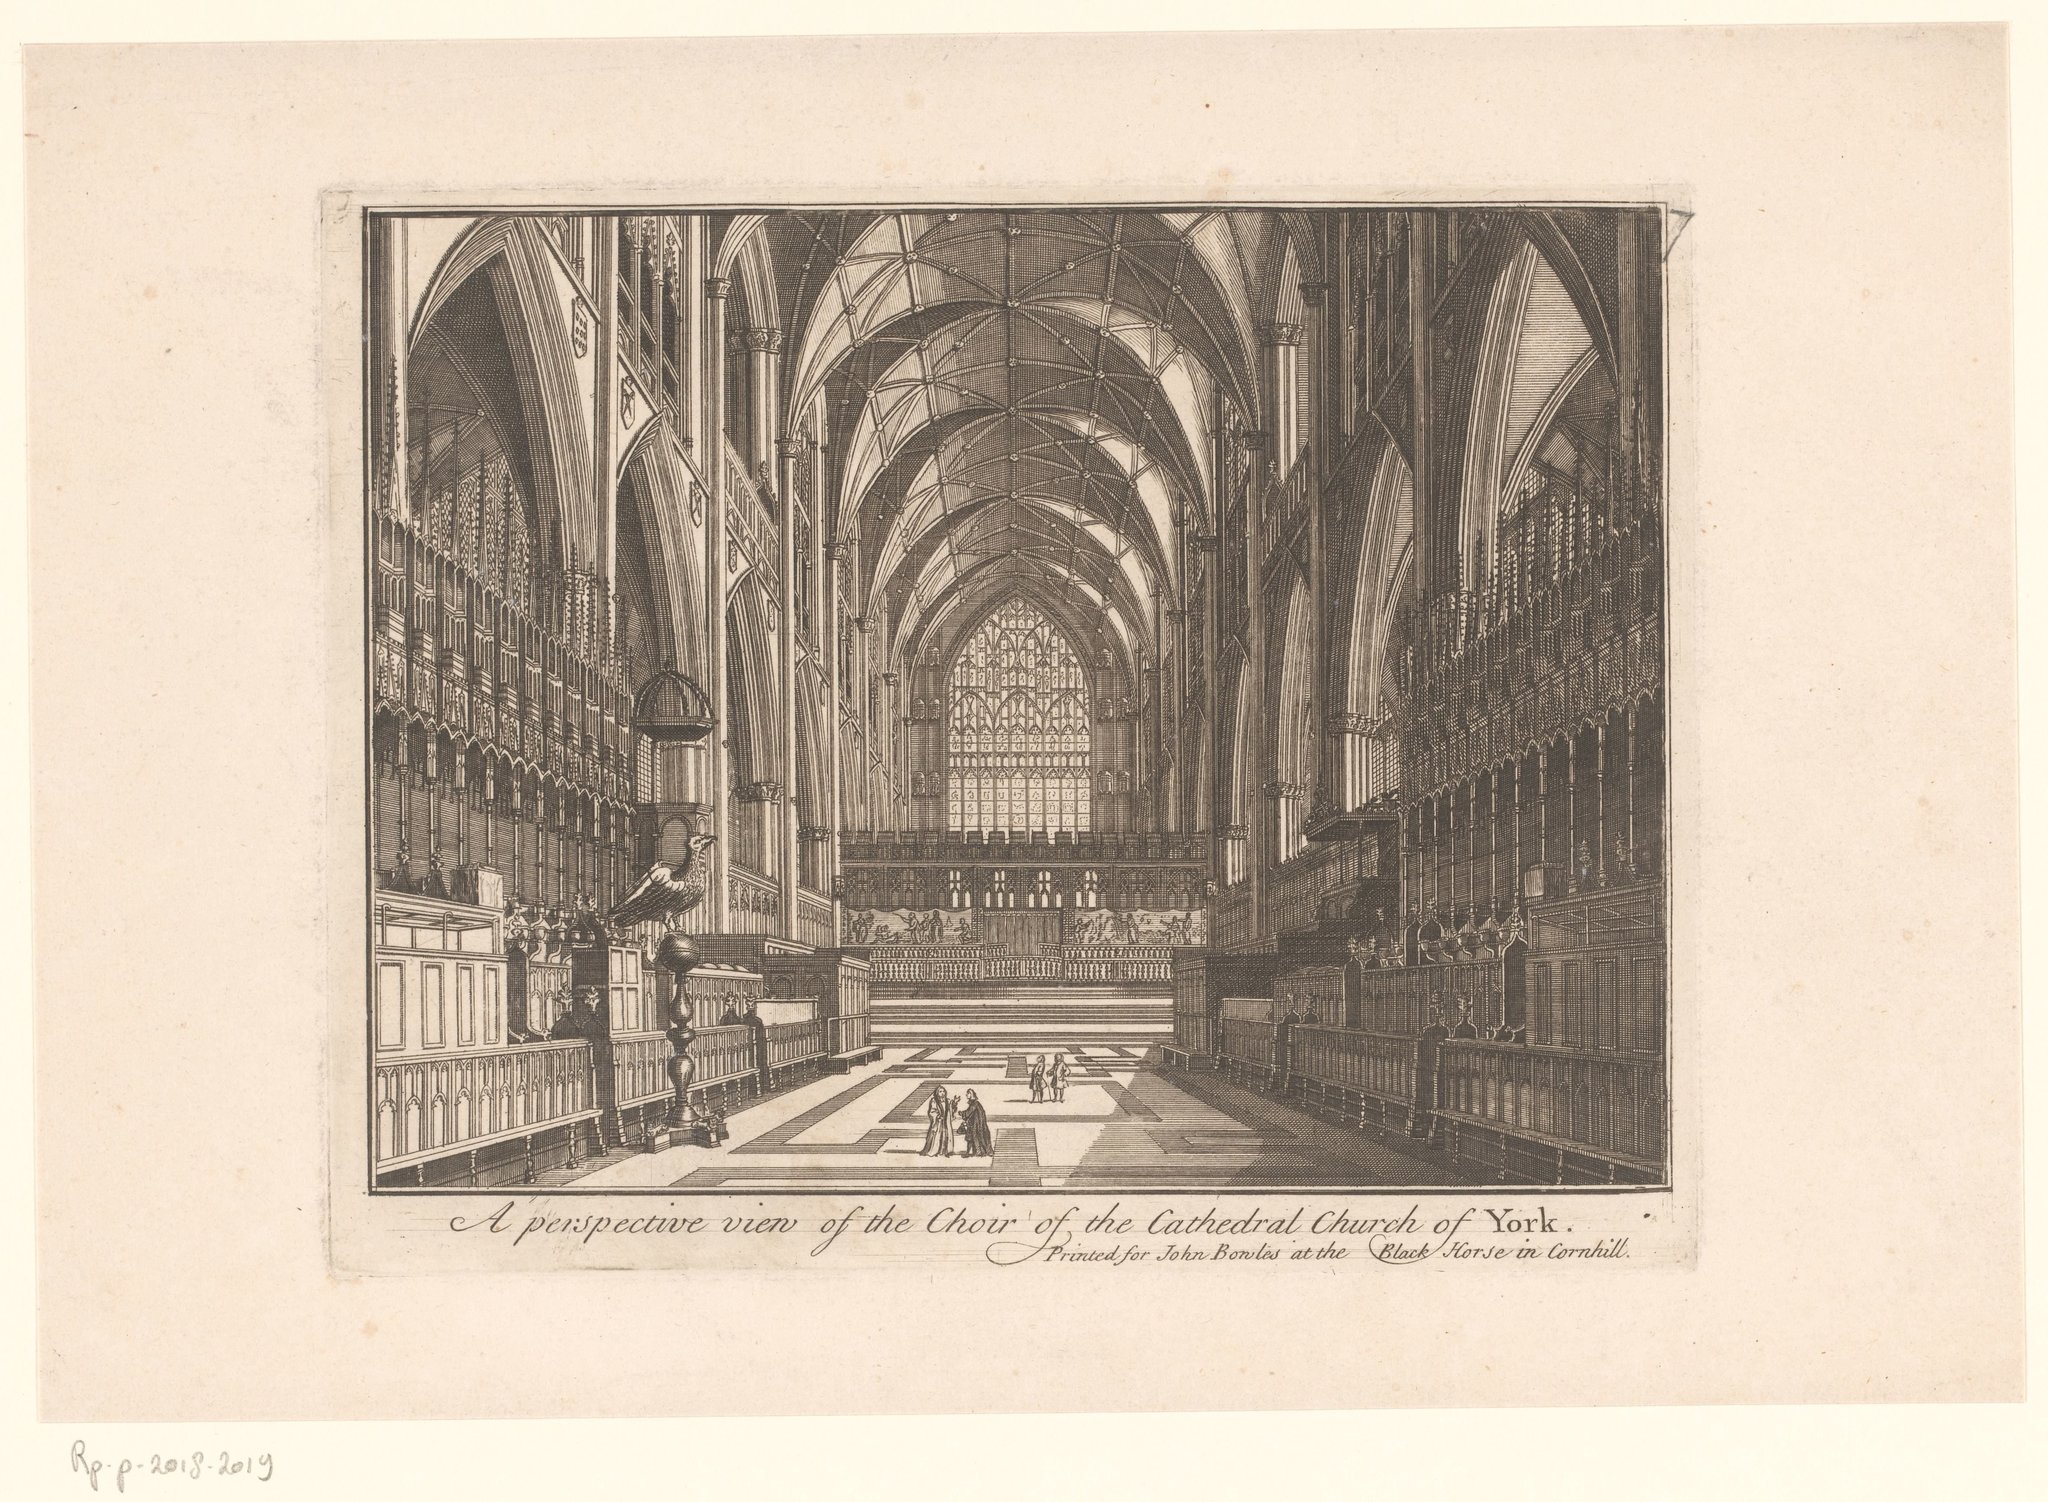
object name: print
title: Gezicht op het interieur van de kathedraal van York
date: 1733-1766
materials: paper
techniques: engraving, etching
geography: london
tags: interior of church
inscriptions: collector's mark: Lugt 2228